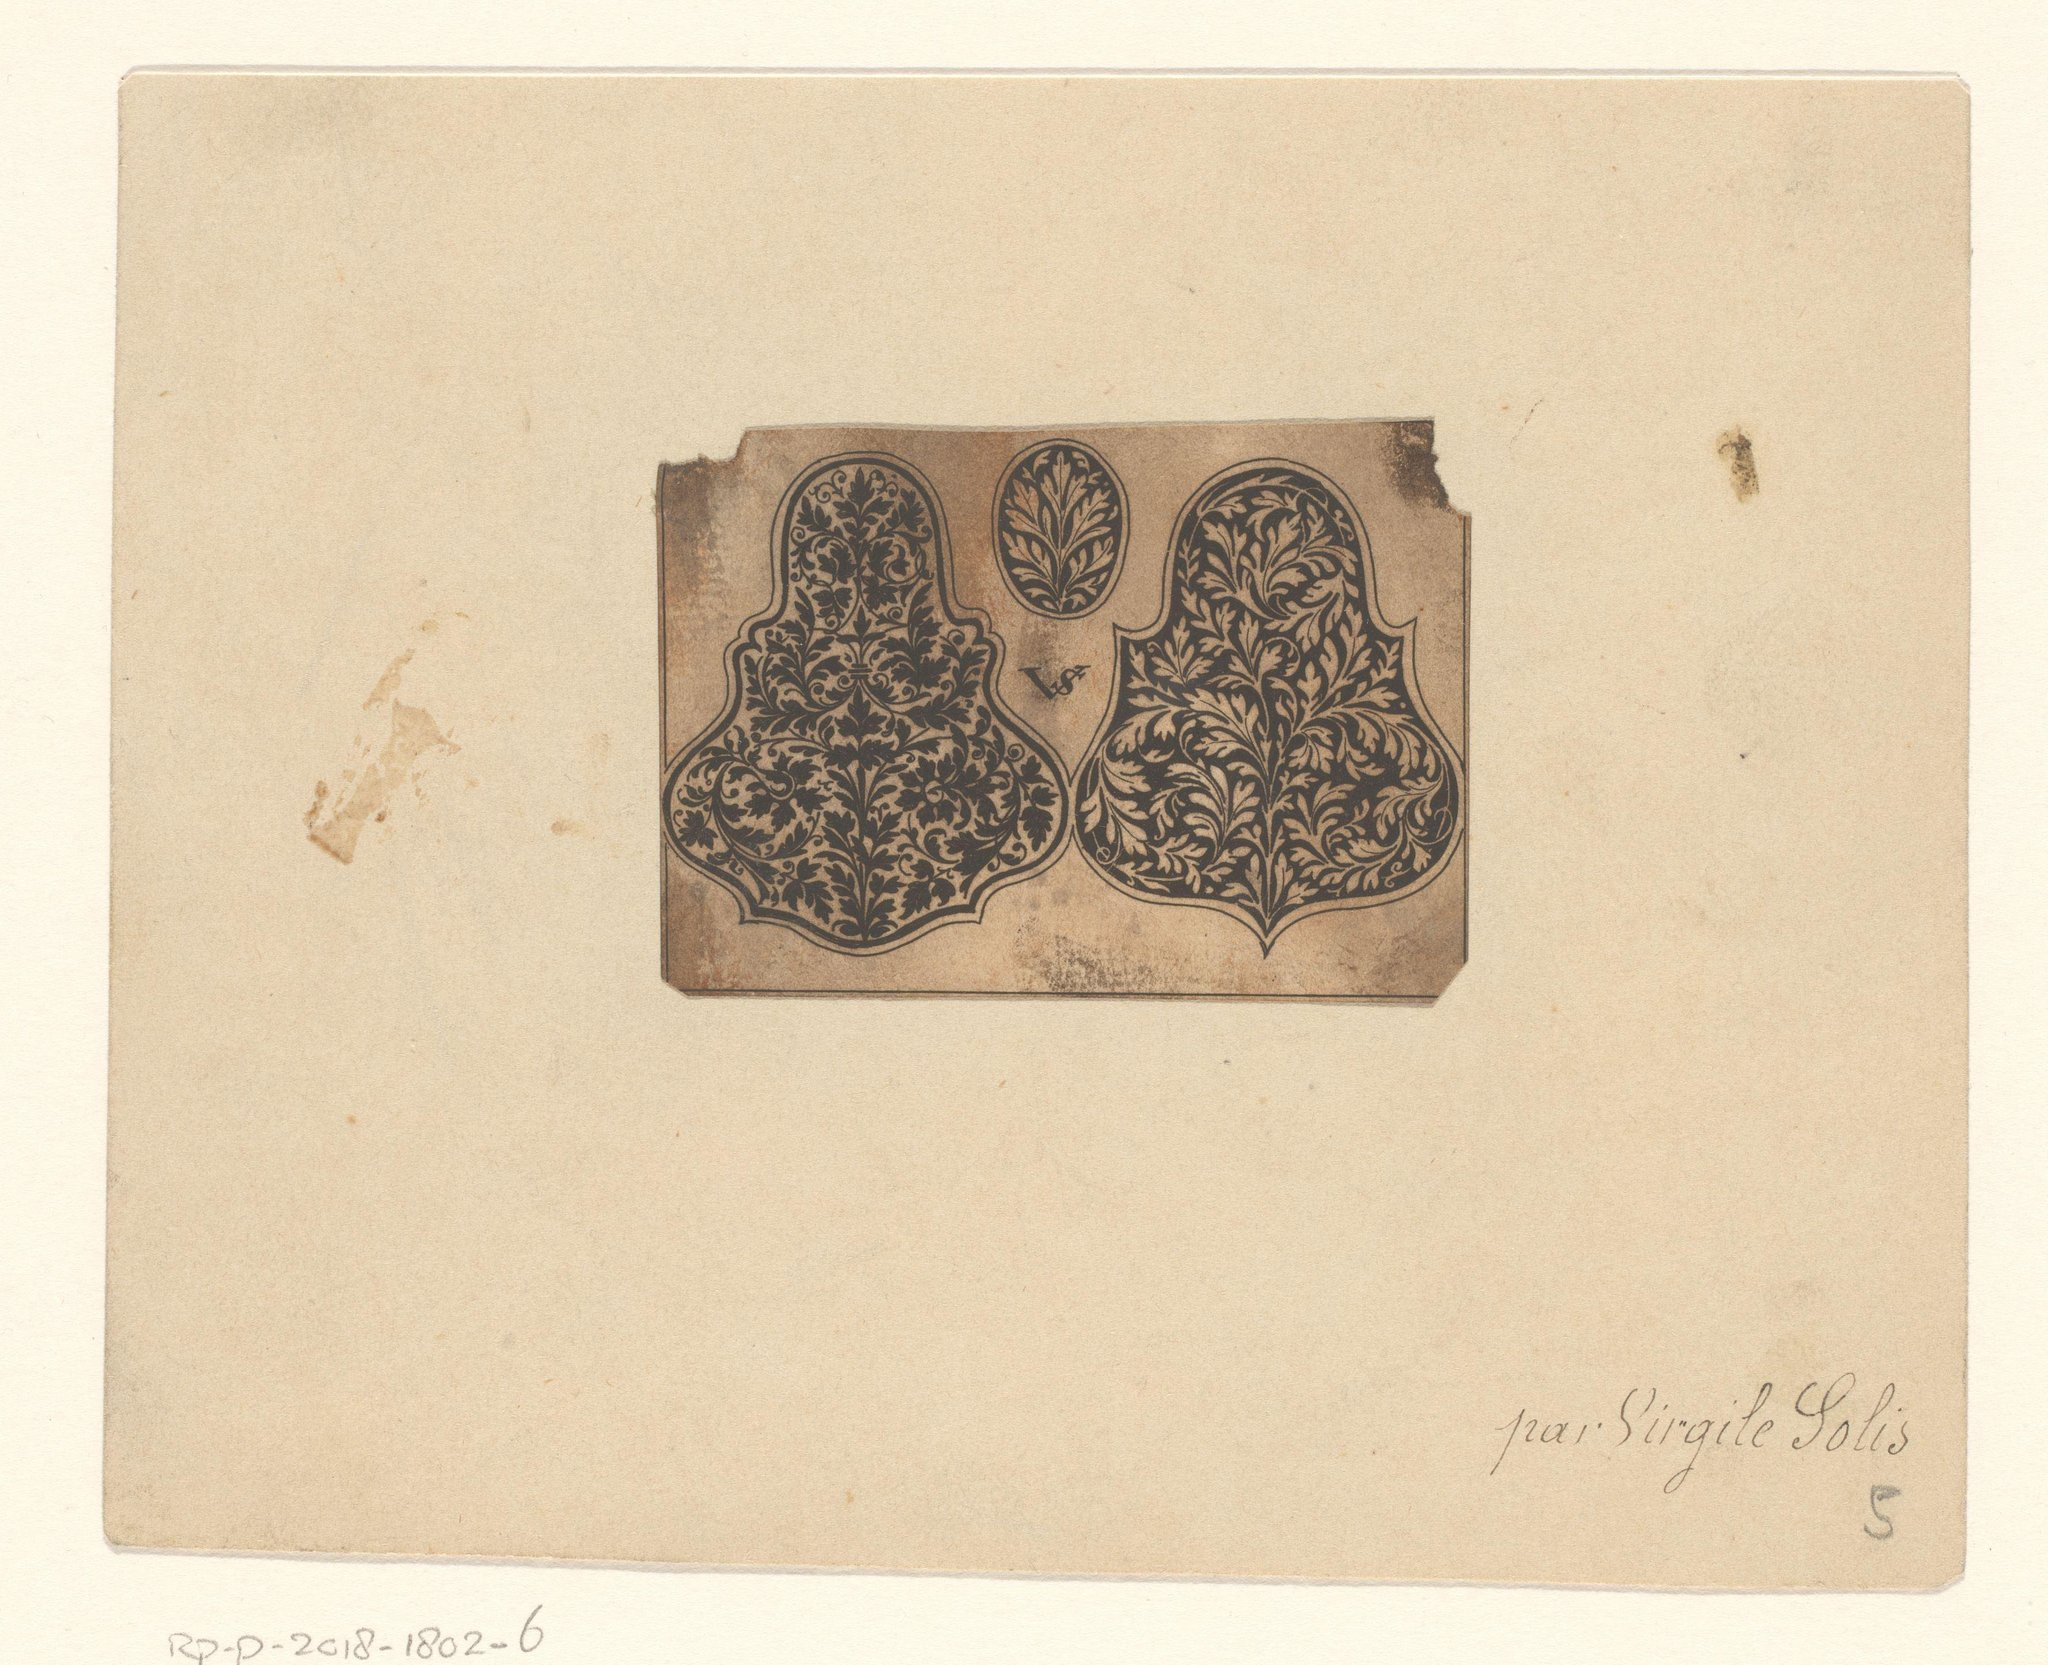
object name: print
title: Ten designs for ornaments with foliage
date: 1553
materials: paper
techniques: engraving, etching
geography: germany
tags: foliage ~ ornament, ornament derived from plant forms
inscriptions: monogram: ‘VS’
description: Drie hangervormige ontwerpen met bladwerk, mogelijk een kopie.